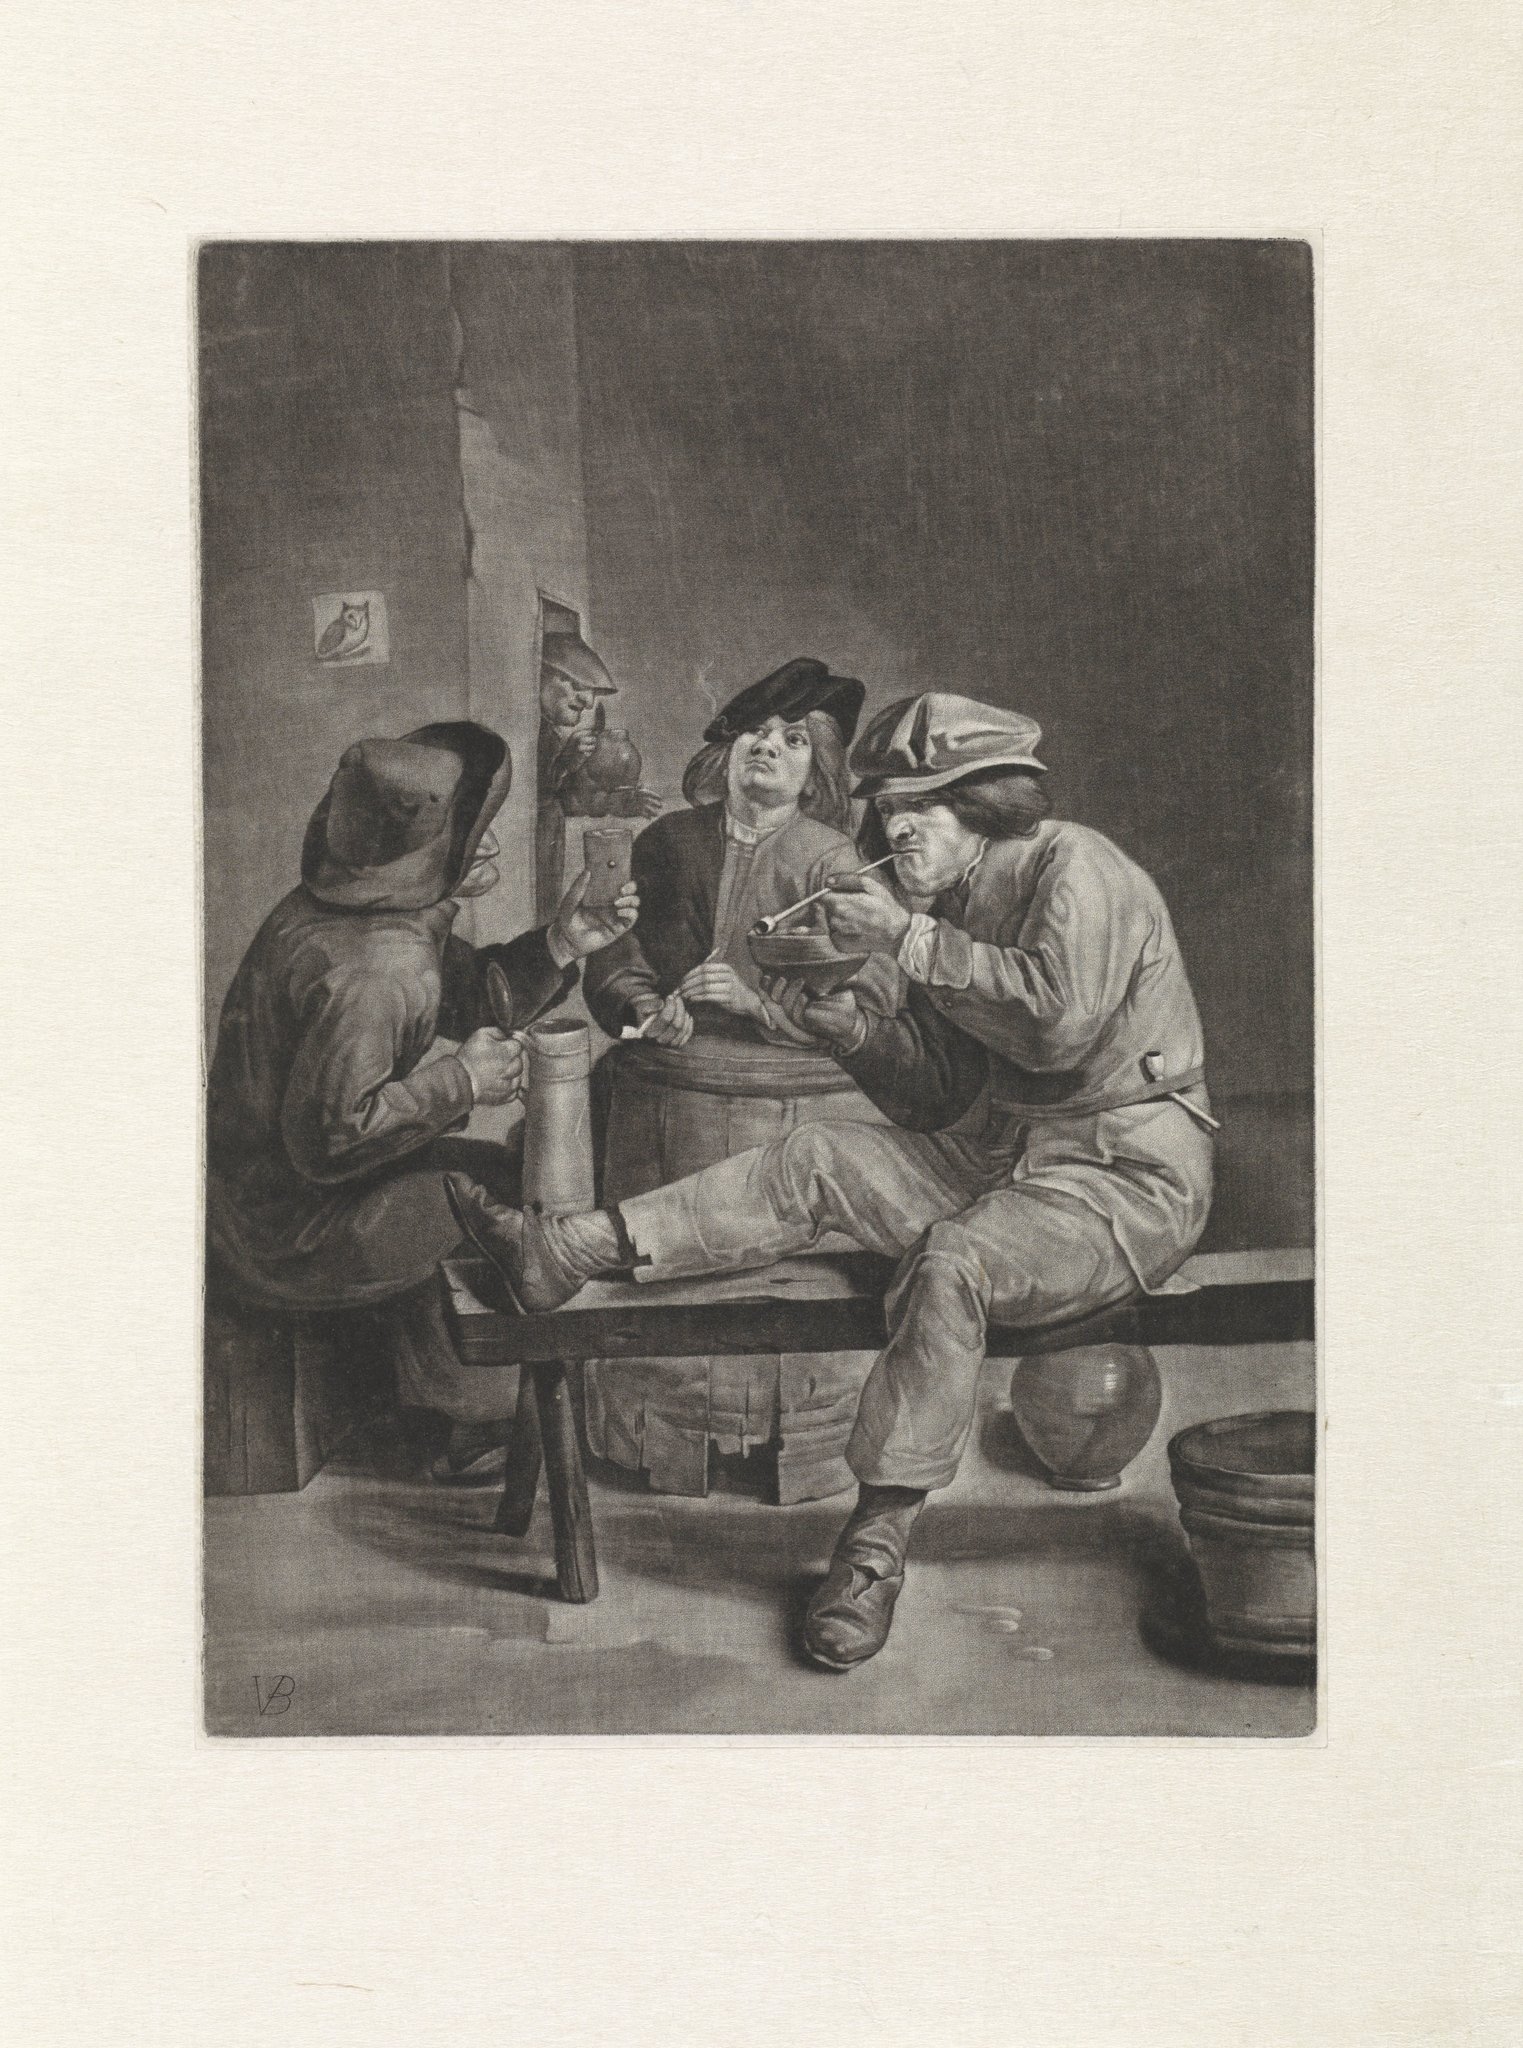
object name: print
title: Rokende en drinkende mannen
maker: jan van der bruggen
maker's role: draughtsman, print maker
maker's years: 1649-1709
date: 1685-1690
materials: paper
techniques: engraving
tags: inn, coffee-house, public house, etc., pipe ~ tobacco, attributes of minerva: owl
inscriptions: collector's mark: Lugt 240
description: In een kroeg zitten drie mannen te roken en te drinken. Een man met in de hand een pul komt het vertrek binnen. Aan de muur hangt een afbeelding van een uil.